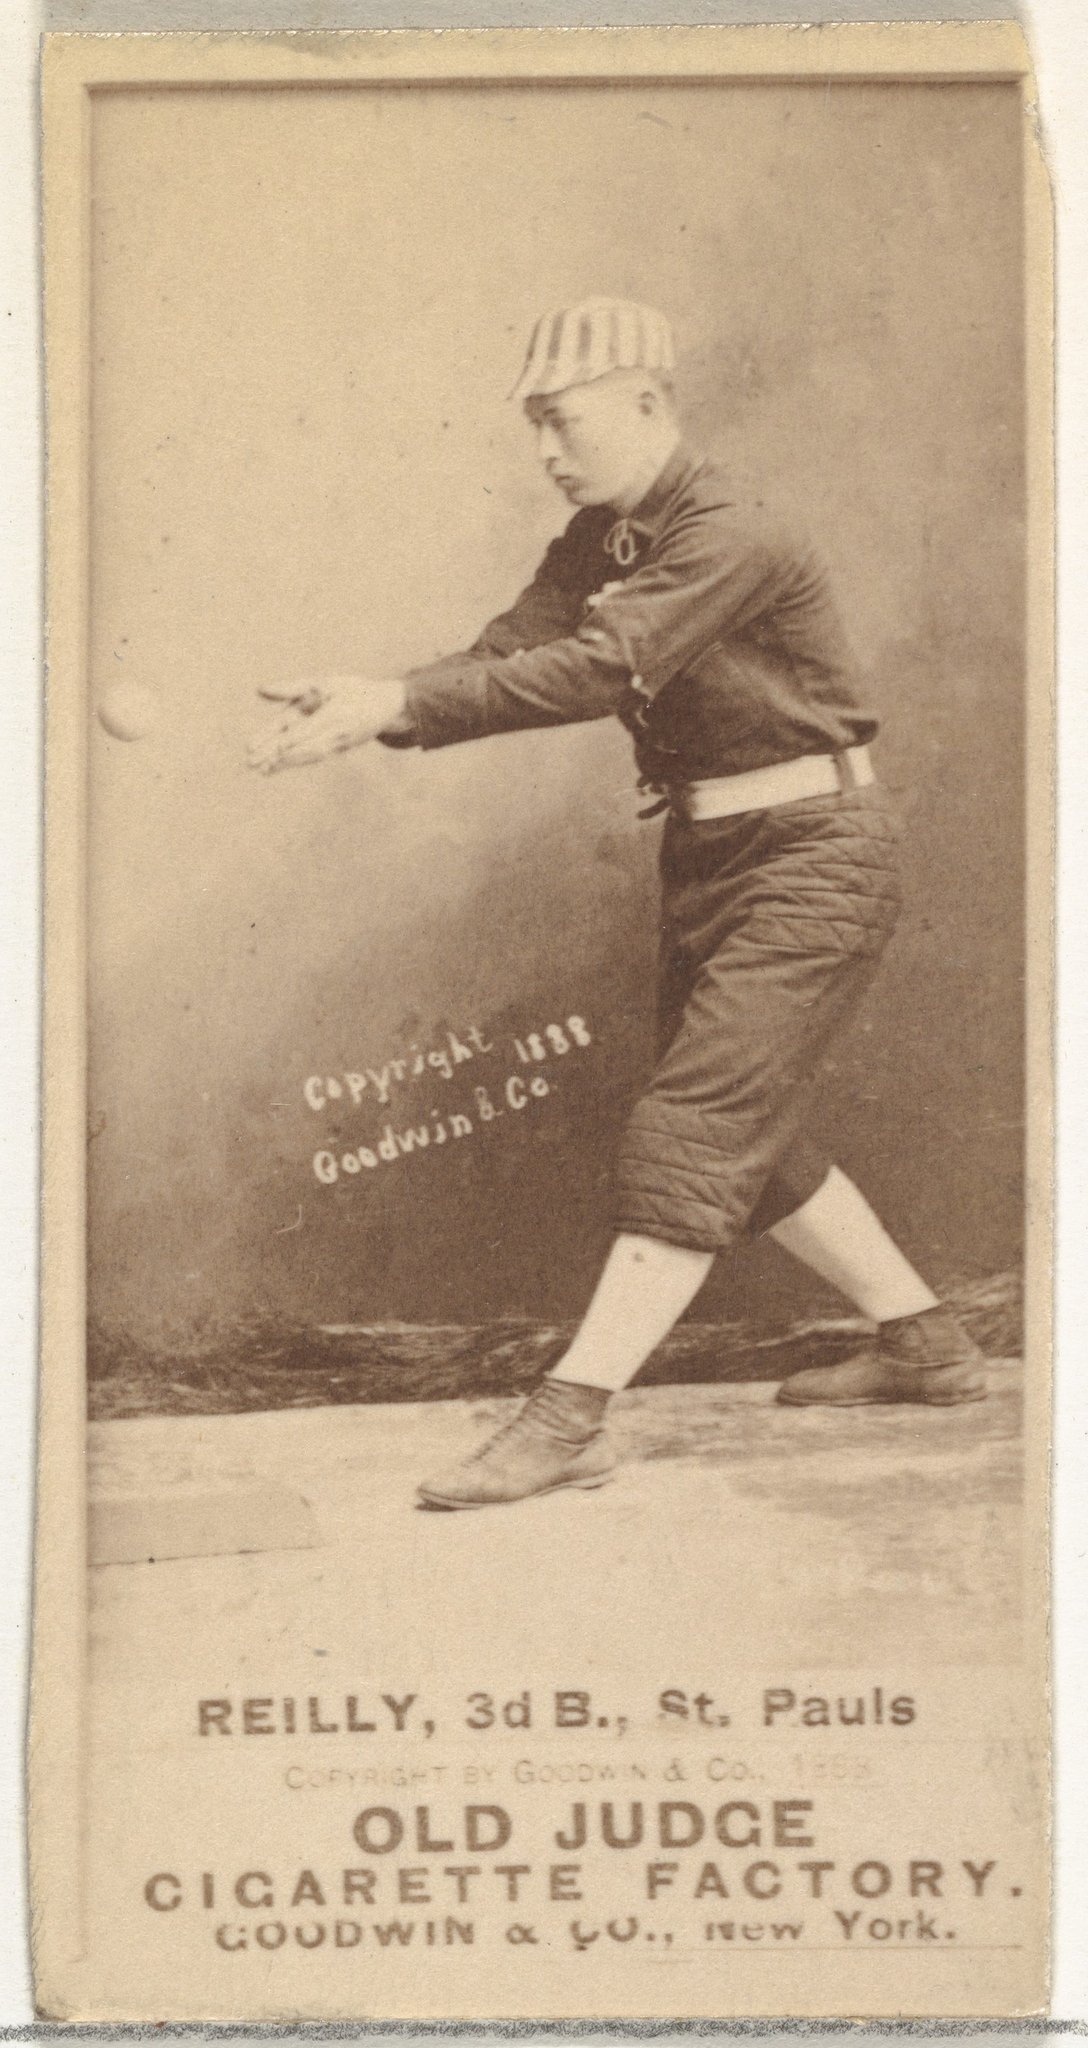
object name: baseball card, photograph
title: Charles Thomas "Charlie" Reilly, 3rd Base, St. Paul Apostles, from the Old Judge series (N172) for Old Judge Cigarettes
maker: goodwin & company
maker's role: publisher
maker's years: 1850-1950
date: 1888-1889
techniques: albumen silver print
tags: men,portraits,baseball,athletes